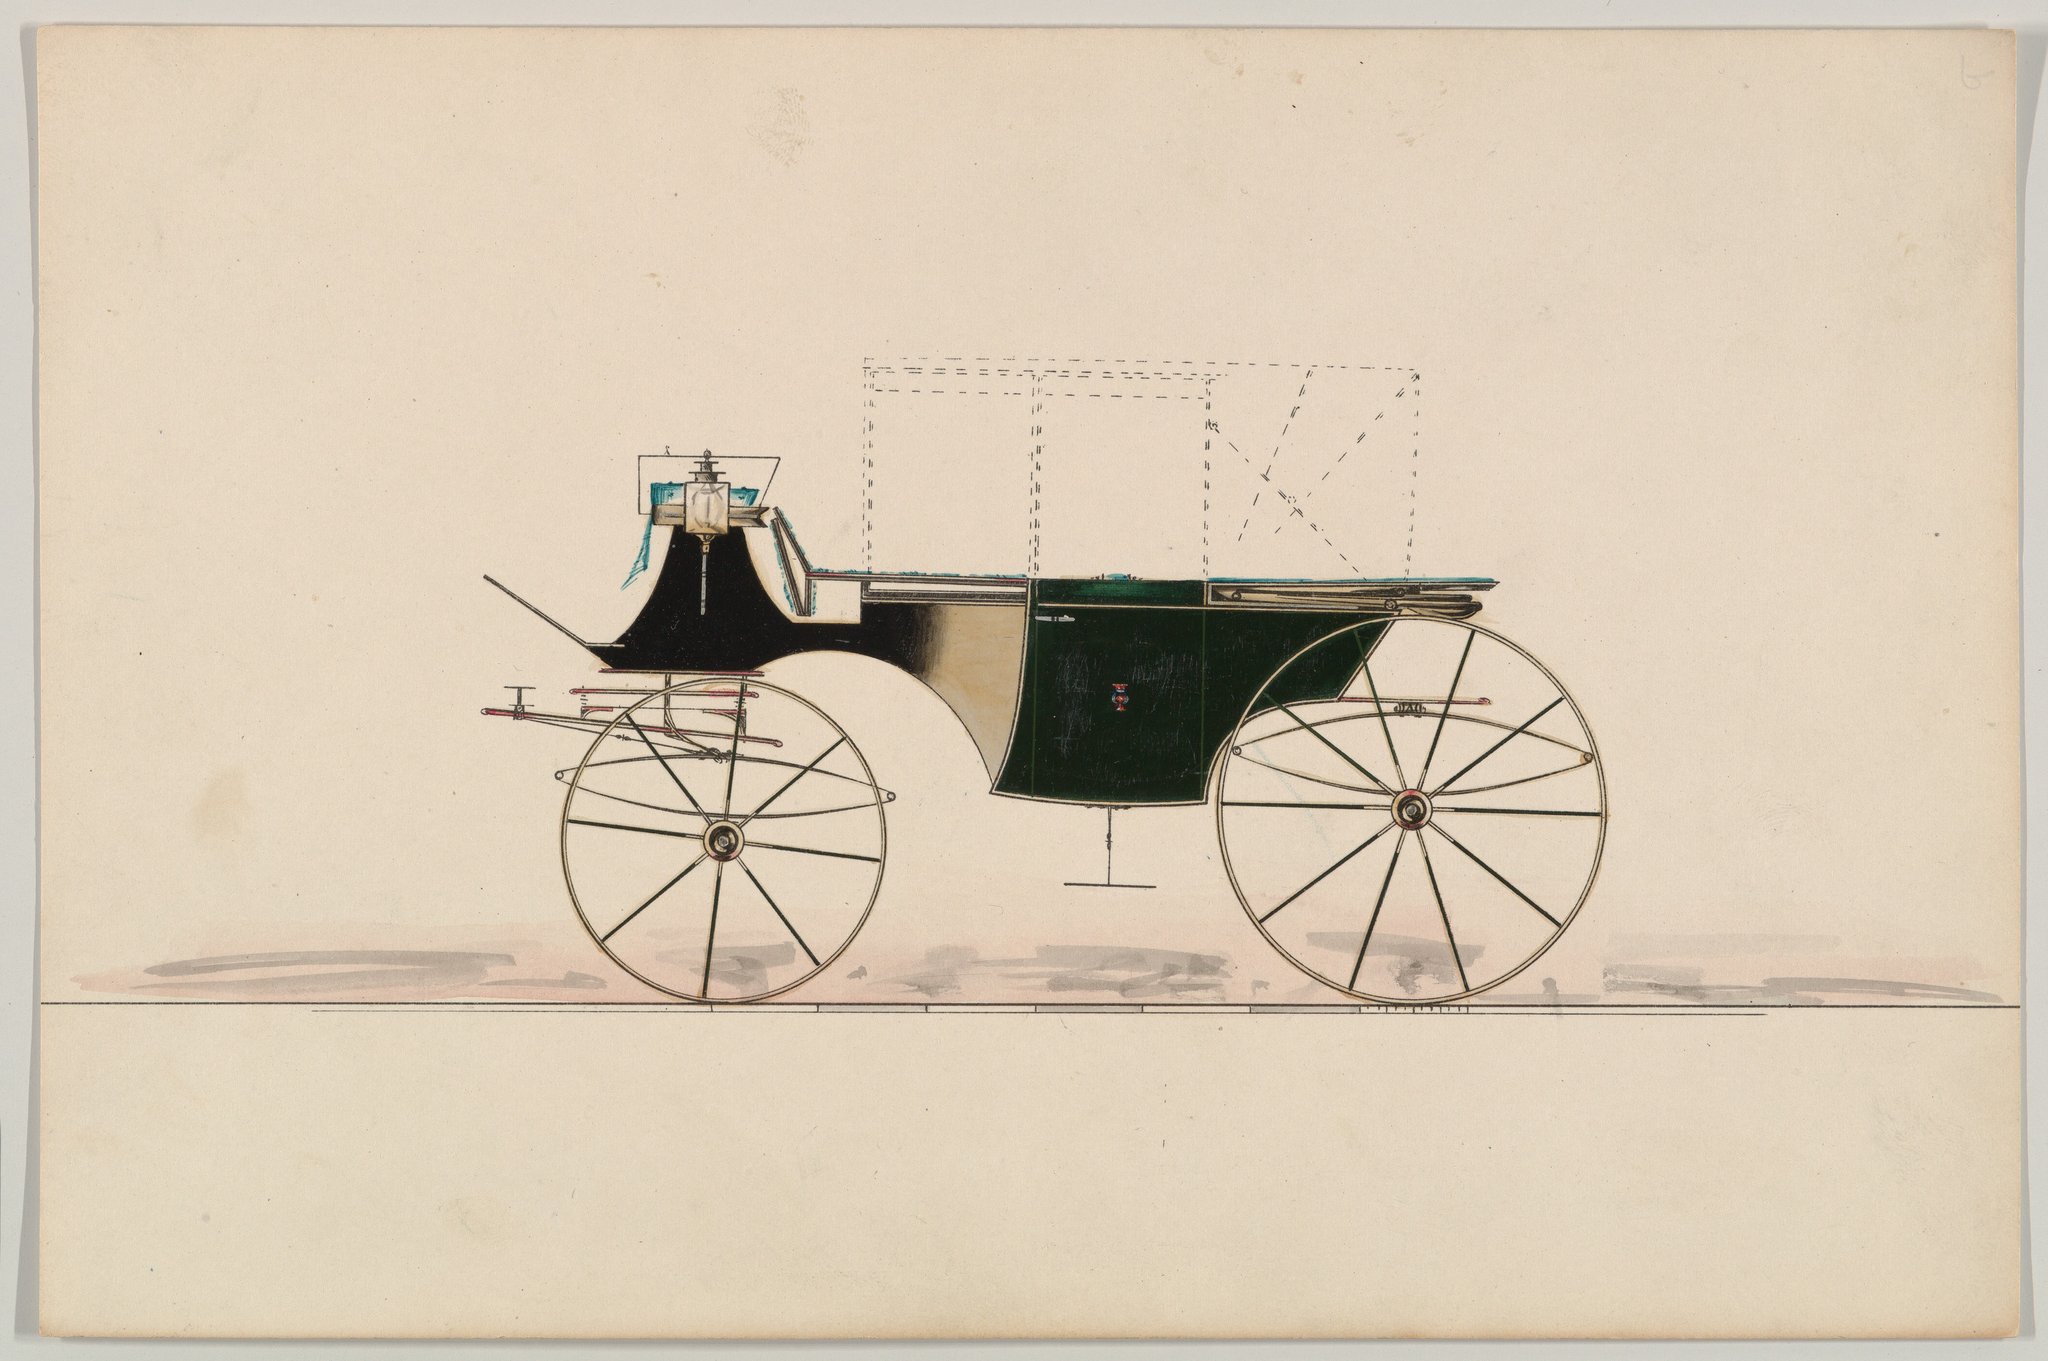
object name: drawing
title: Design for Double Front Landaulet (unnumbered)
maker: brewster & co.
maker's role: manufacturer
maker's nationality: american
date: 1850-1870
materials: gouache, gum arabic, ink, watercolor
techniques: pen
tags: carriages